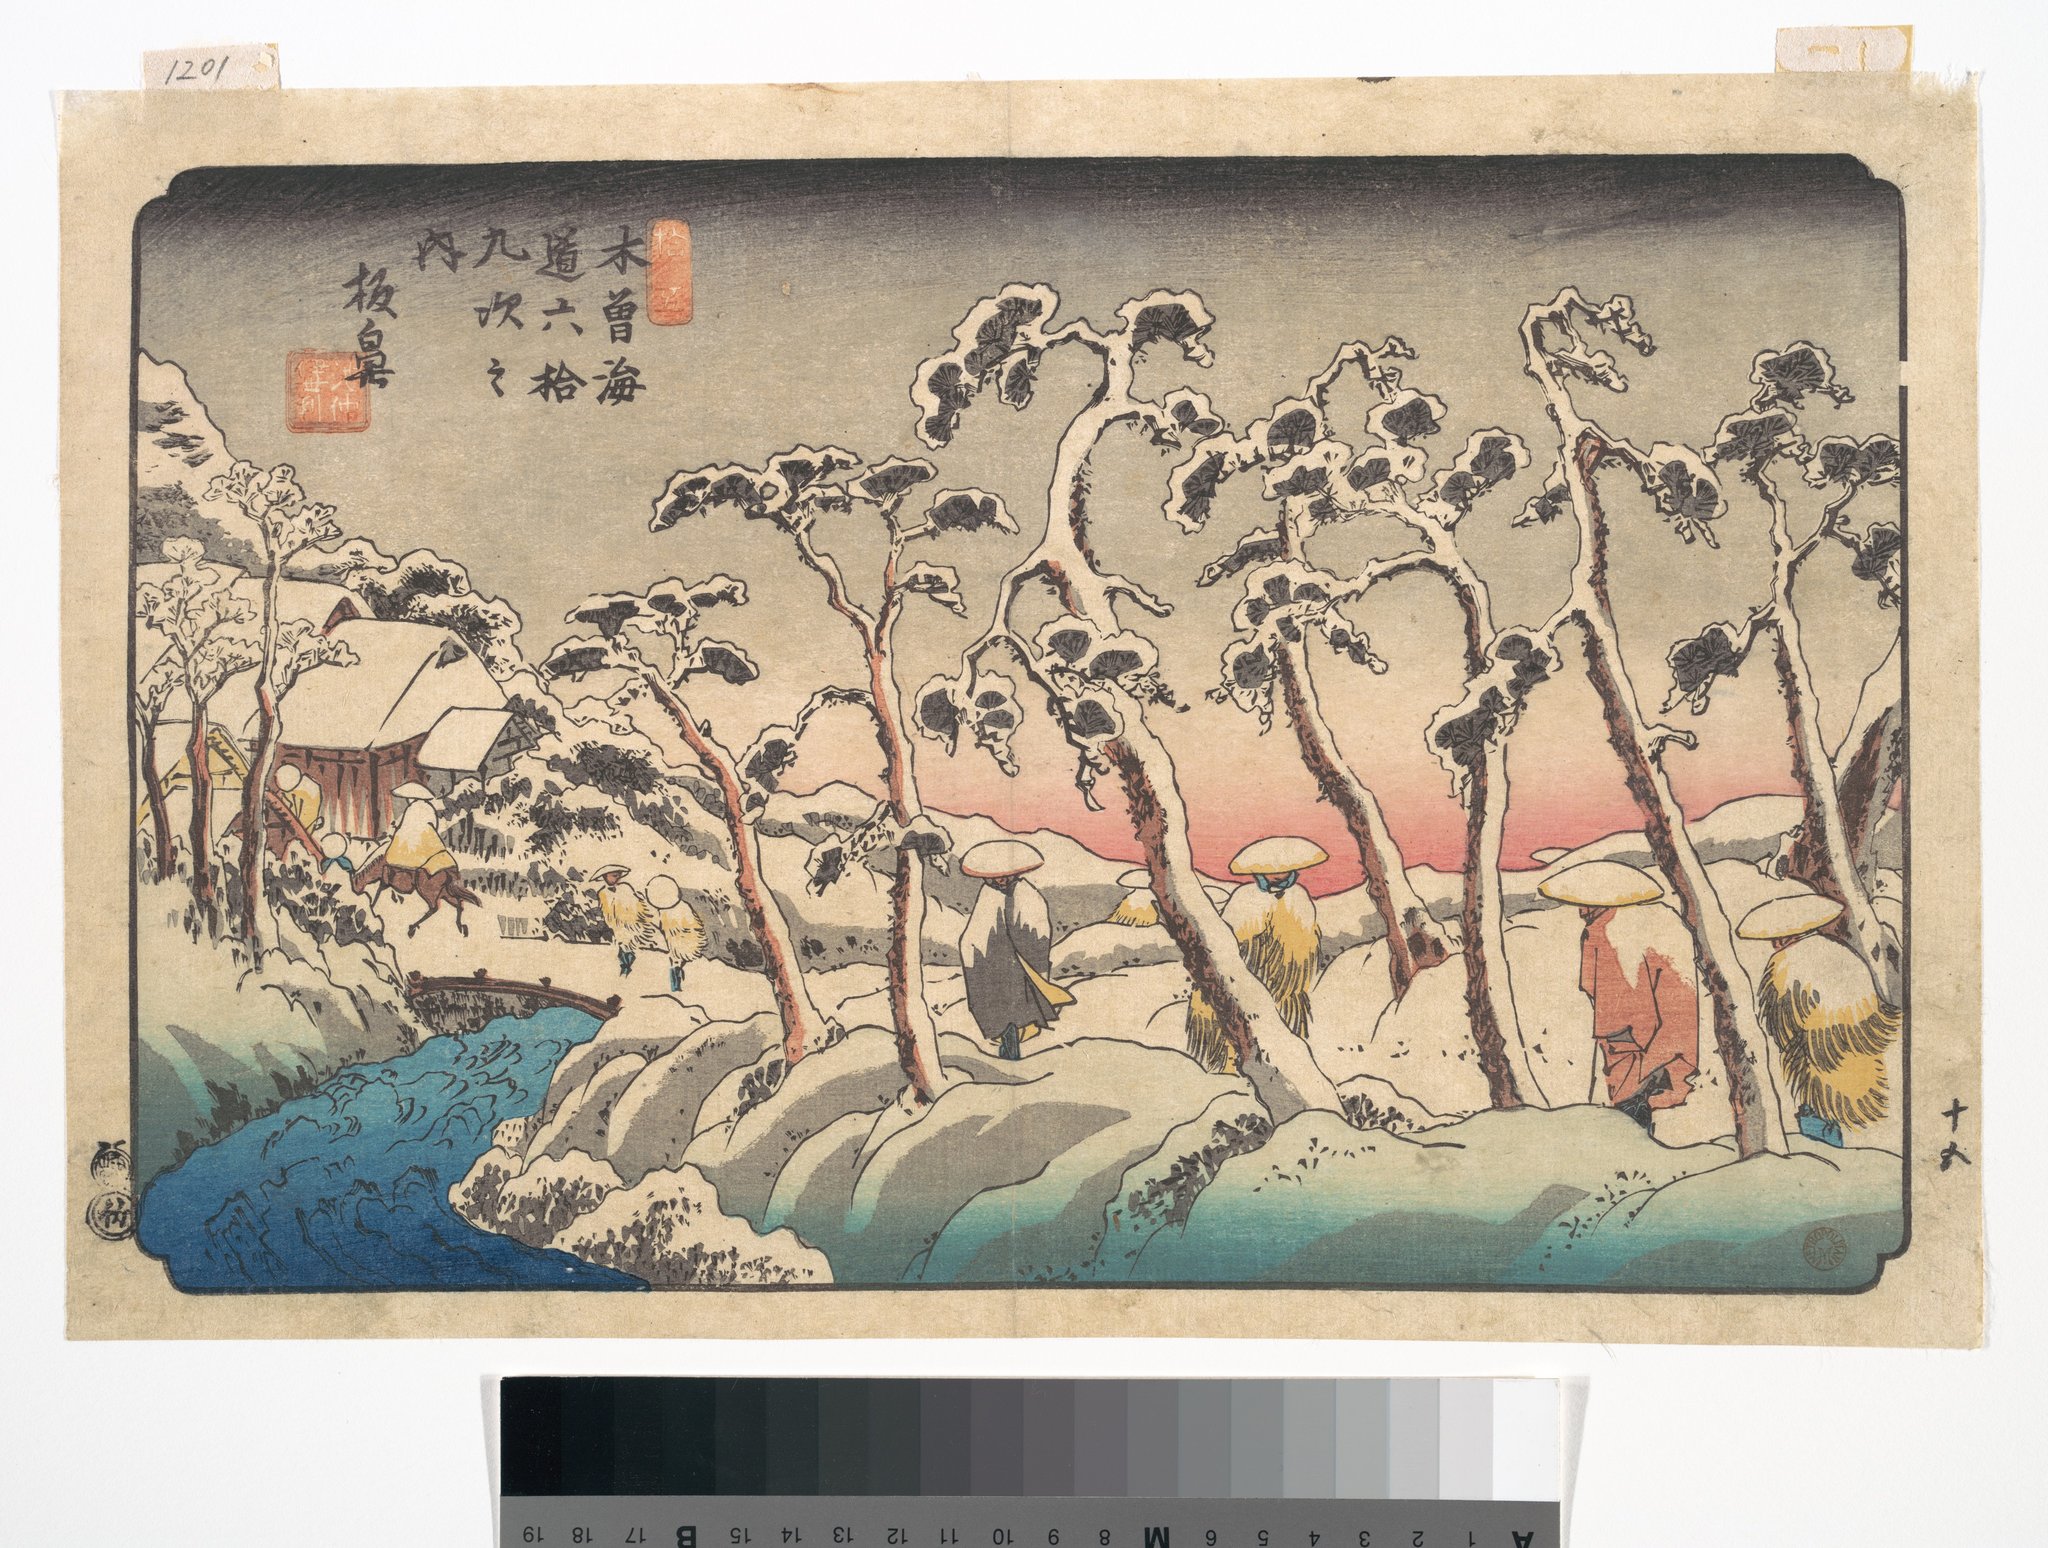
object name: print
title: Itabana Station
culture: japanese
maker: keisai eisen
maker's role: artist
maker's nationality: japanese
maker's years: 1790-1848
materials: ink, paper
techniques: woodblock print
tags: human figures,trees,snow